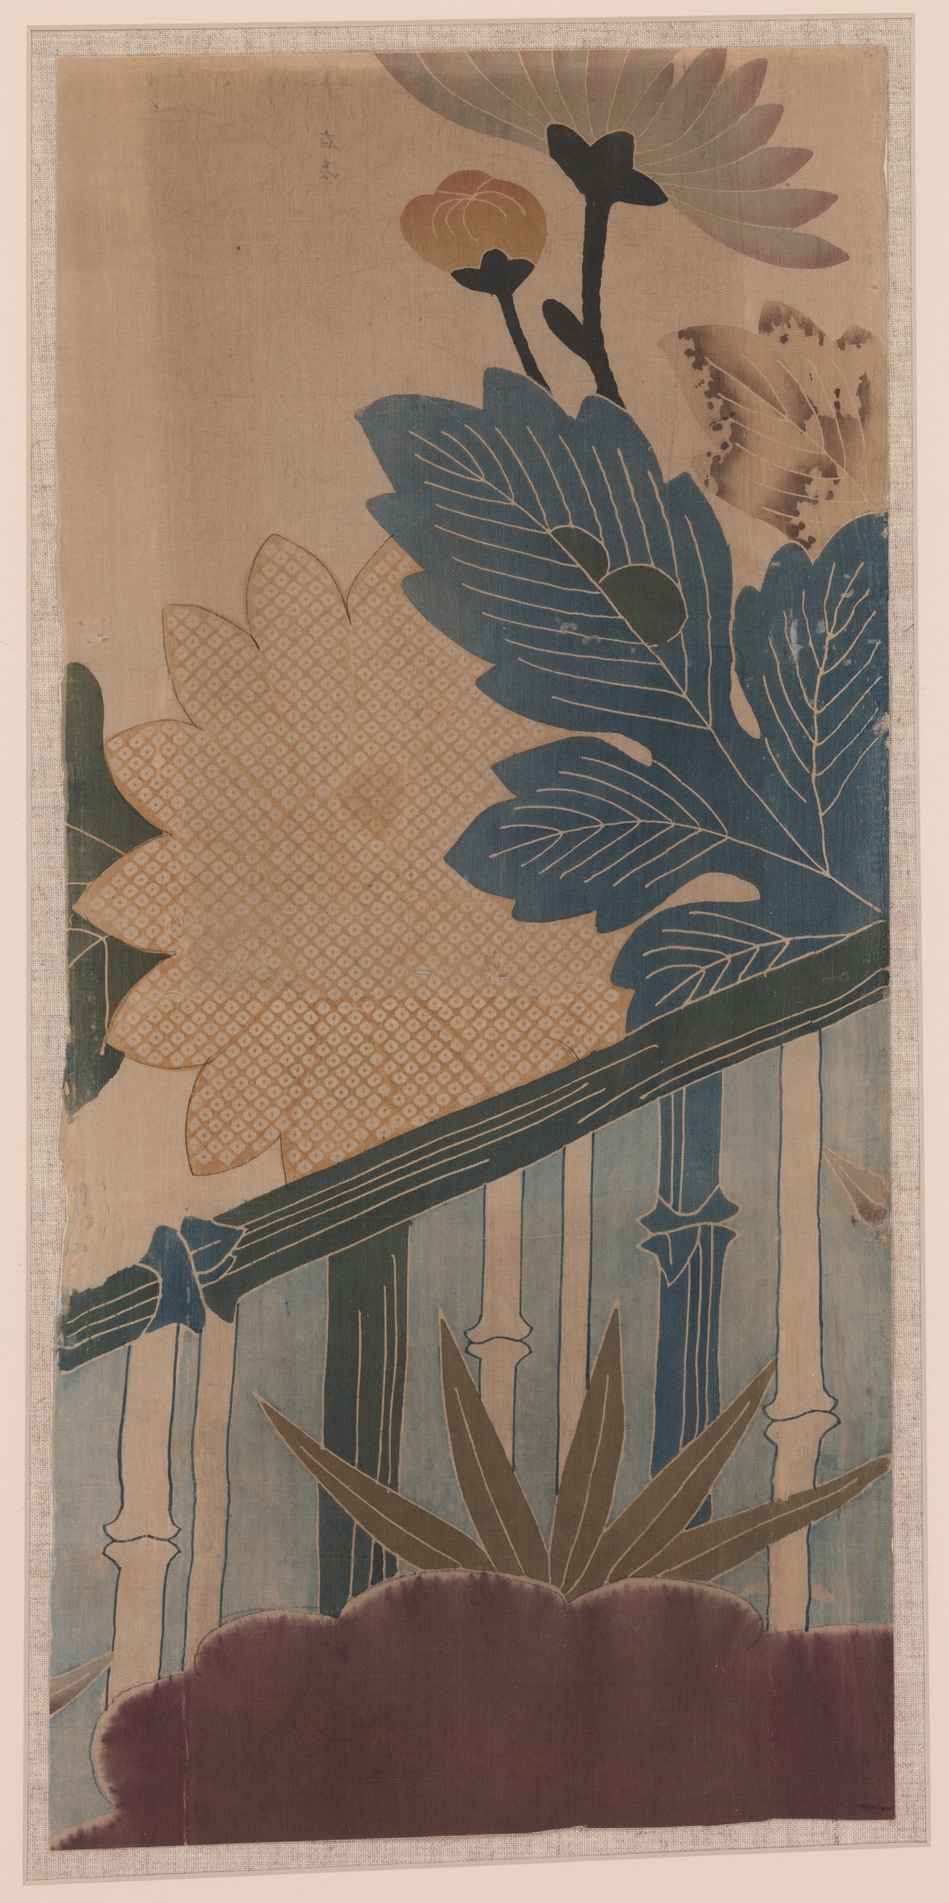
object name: piece from a kosode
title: Two Pieces from a Robe (Kosode) with Chrysanthemums, Clouds, and Bamboo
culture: japanese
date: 1667-1800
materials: paste, silk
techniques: dyeing, painting, weave, resist, stitching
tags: bamboo,leaves